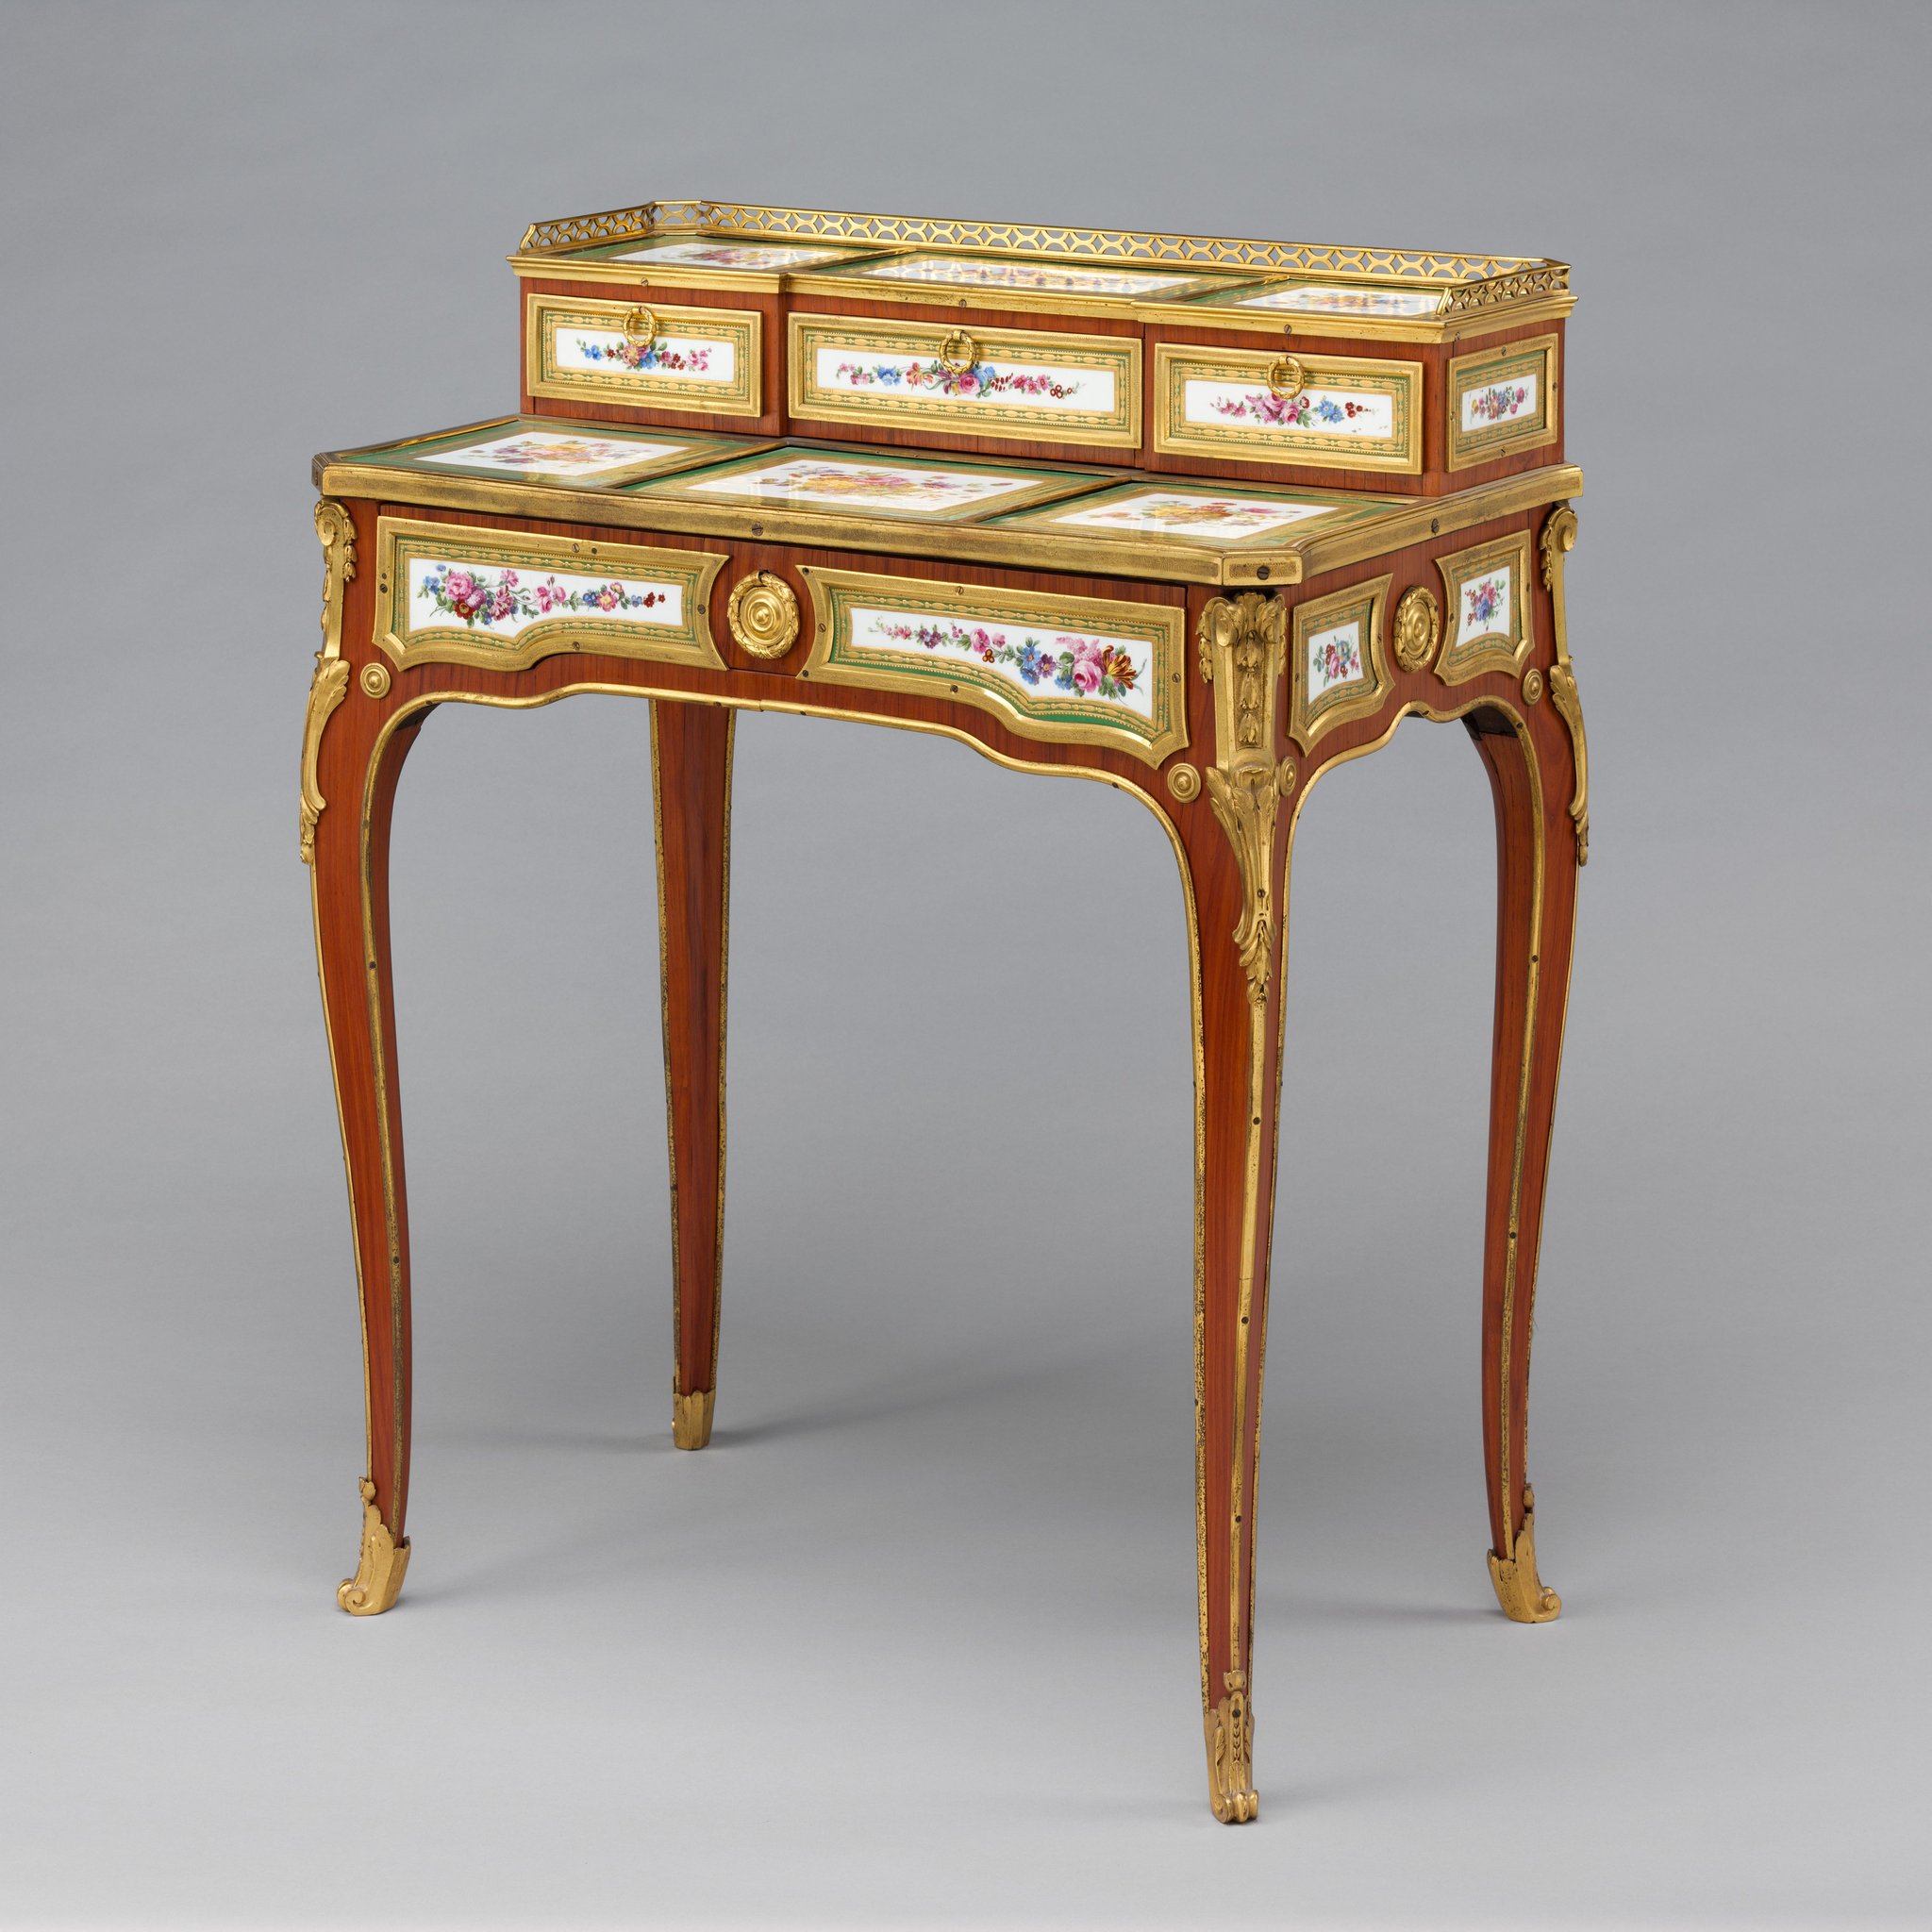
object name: desk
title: Desk (bonheur du jour)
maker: martin carlin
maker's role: maker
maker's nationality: french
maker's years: 1725-1785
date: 1769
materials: wood, gilt bronze, soft paste porcelain